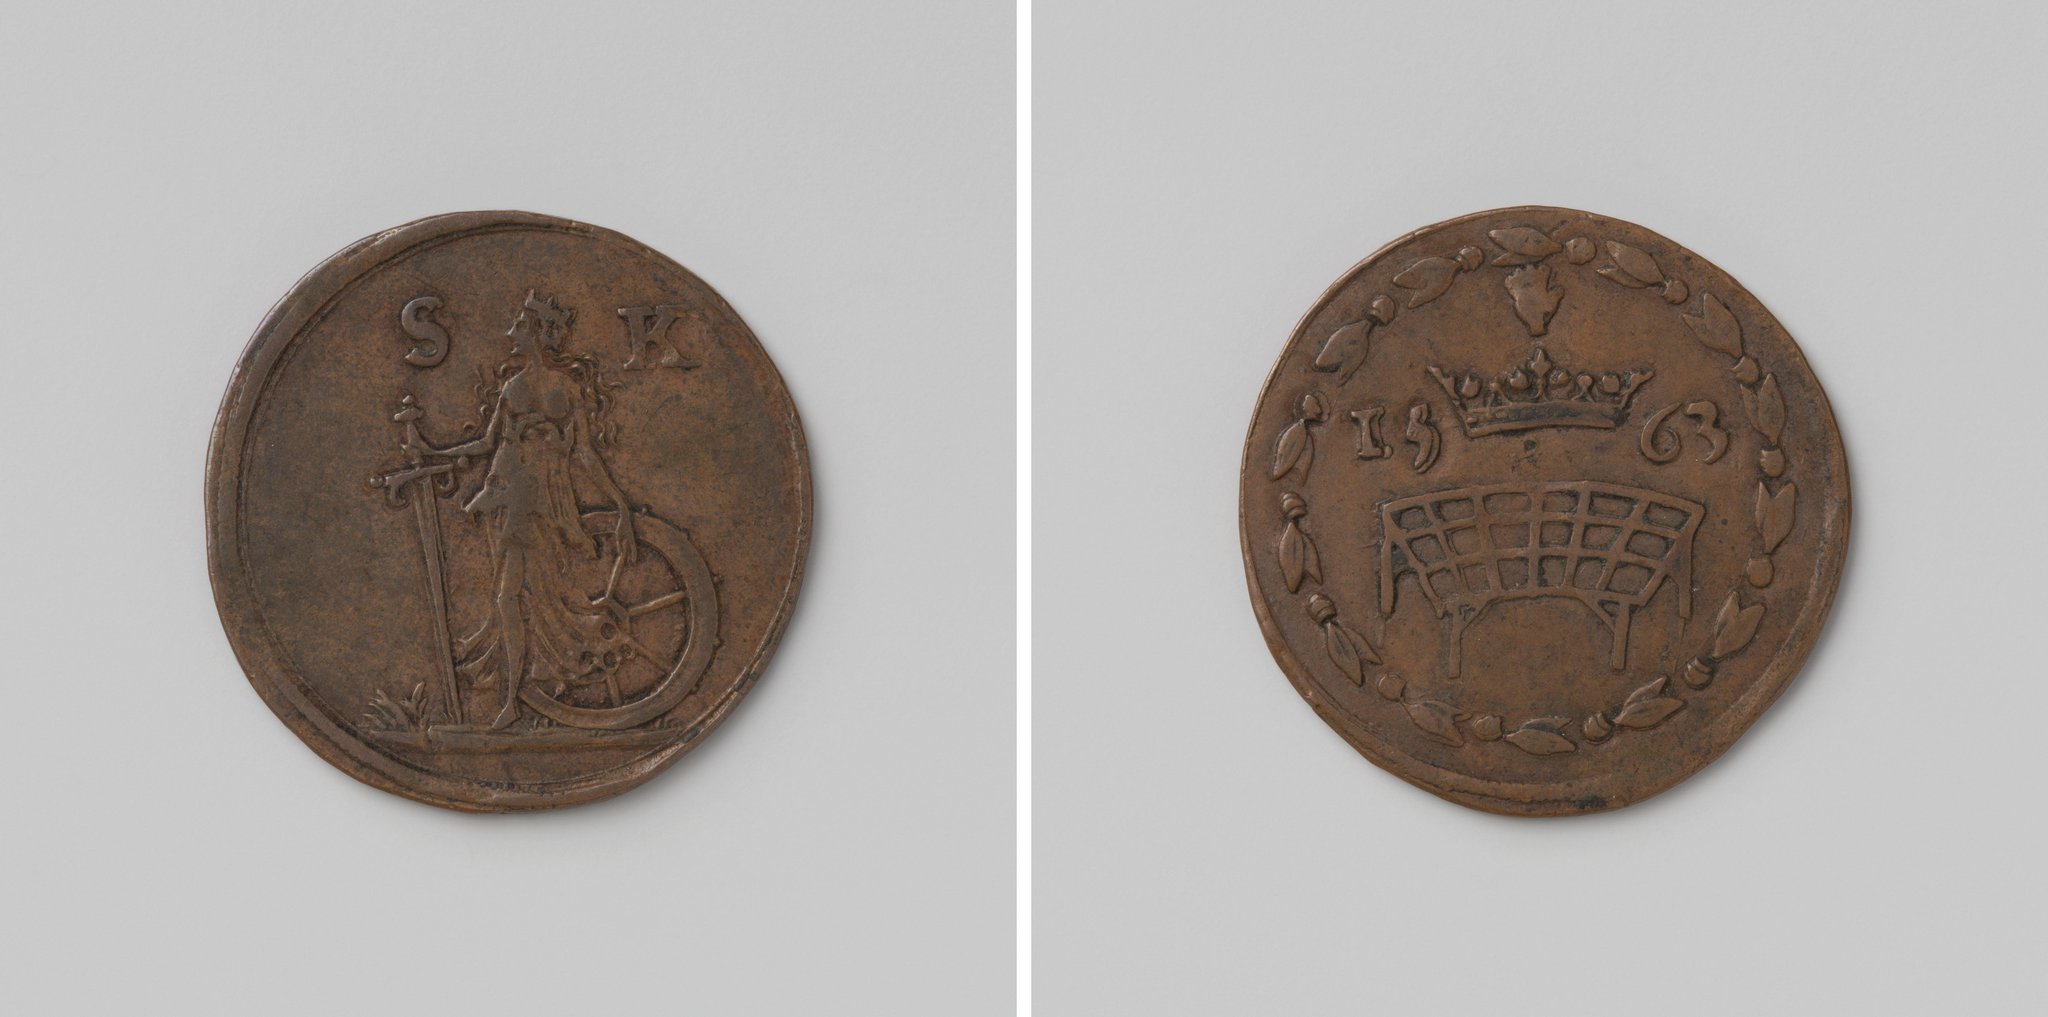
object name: medal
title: Broekenmakersgilde van Antwerpen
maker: Anonymous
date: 1563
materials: copper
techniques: striking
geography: antwerp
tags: antwerp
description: Koperen penning. Voorzijde: vrouw, voorstellende St. Catherina, staande tussen letters S en K houdt zwaard met punt op grond in rechter- en rad in linkerhand. Keerzijde: bed of tafel onder kroon tussen jaartal en geopende hand binnen bladerkrans.